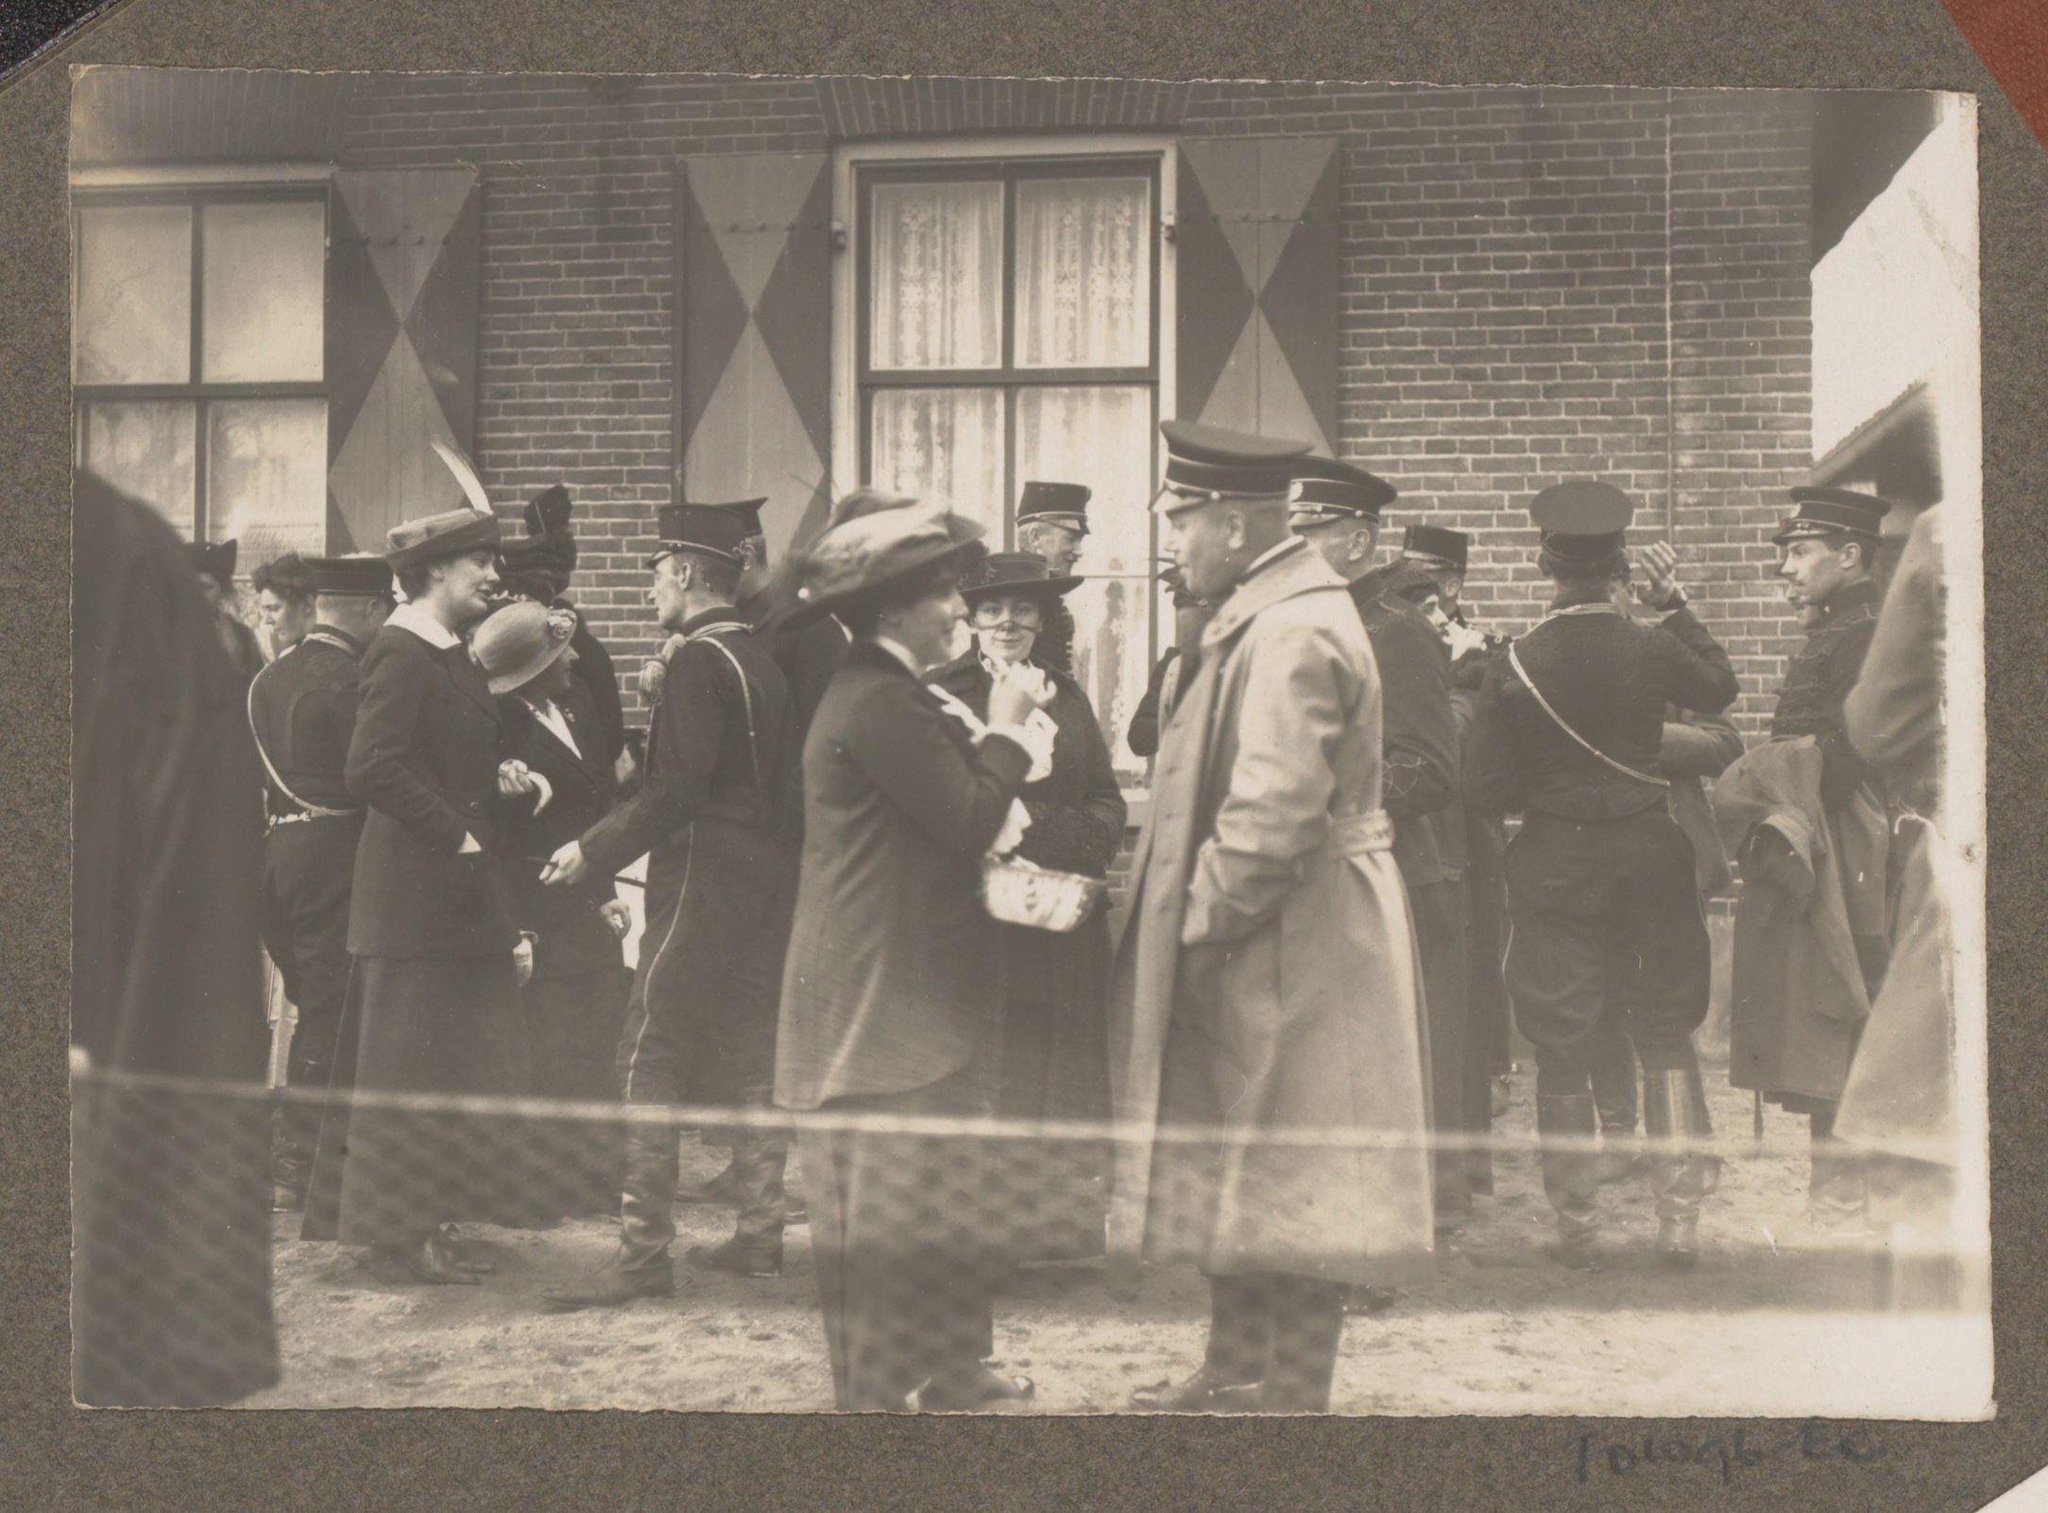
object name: album leaf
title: Ruitertafereel op Koninklijke Houtvesterij Het Loo: gezelschap bij een huis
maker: Anonymous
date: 1900-1925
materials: photographic support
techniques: gelatin silver print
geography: het loo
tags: hunting, chase, hunting-ground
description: Onderdeel van Fotoalbum van de heer Brams, opperhoutvester van koningin Wilhelmina op Koninklijke Houtvesterij Het Loo.